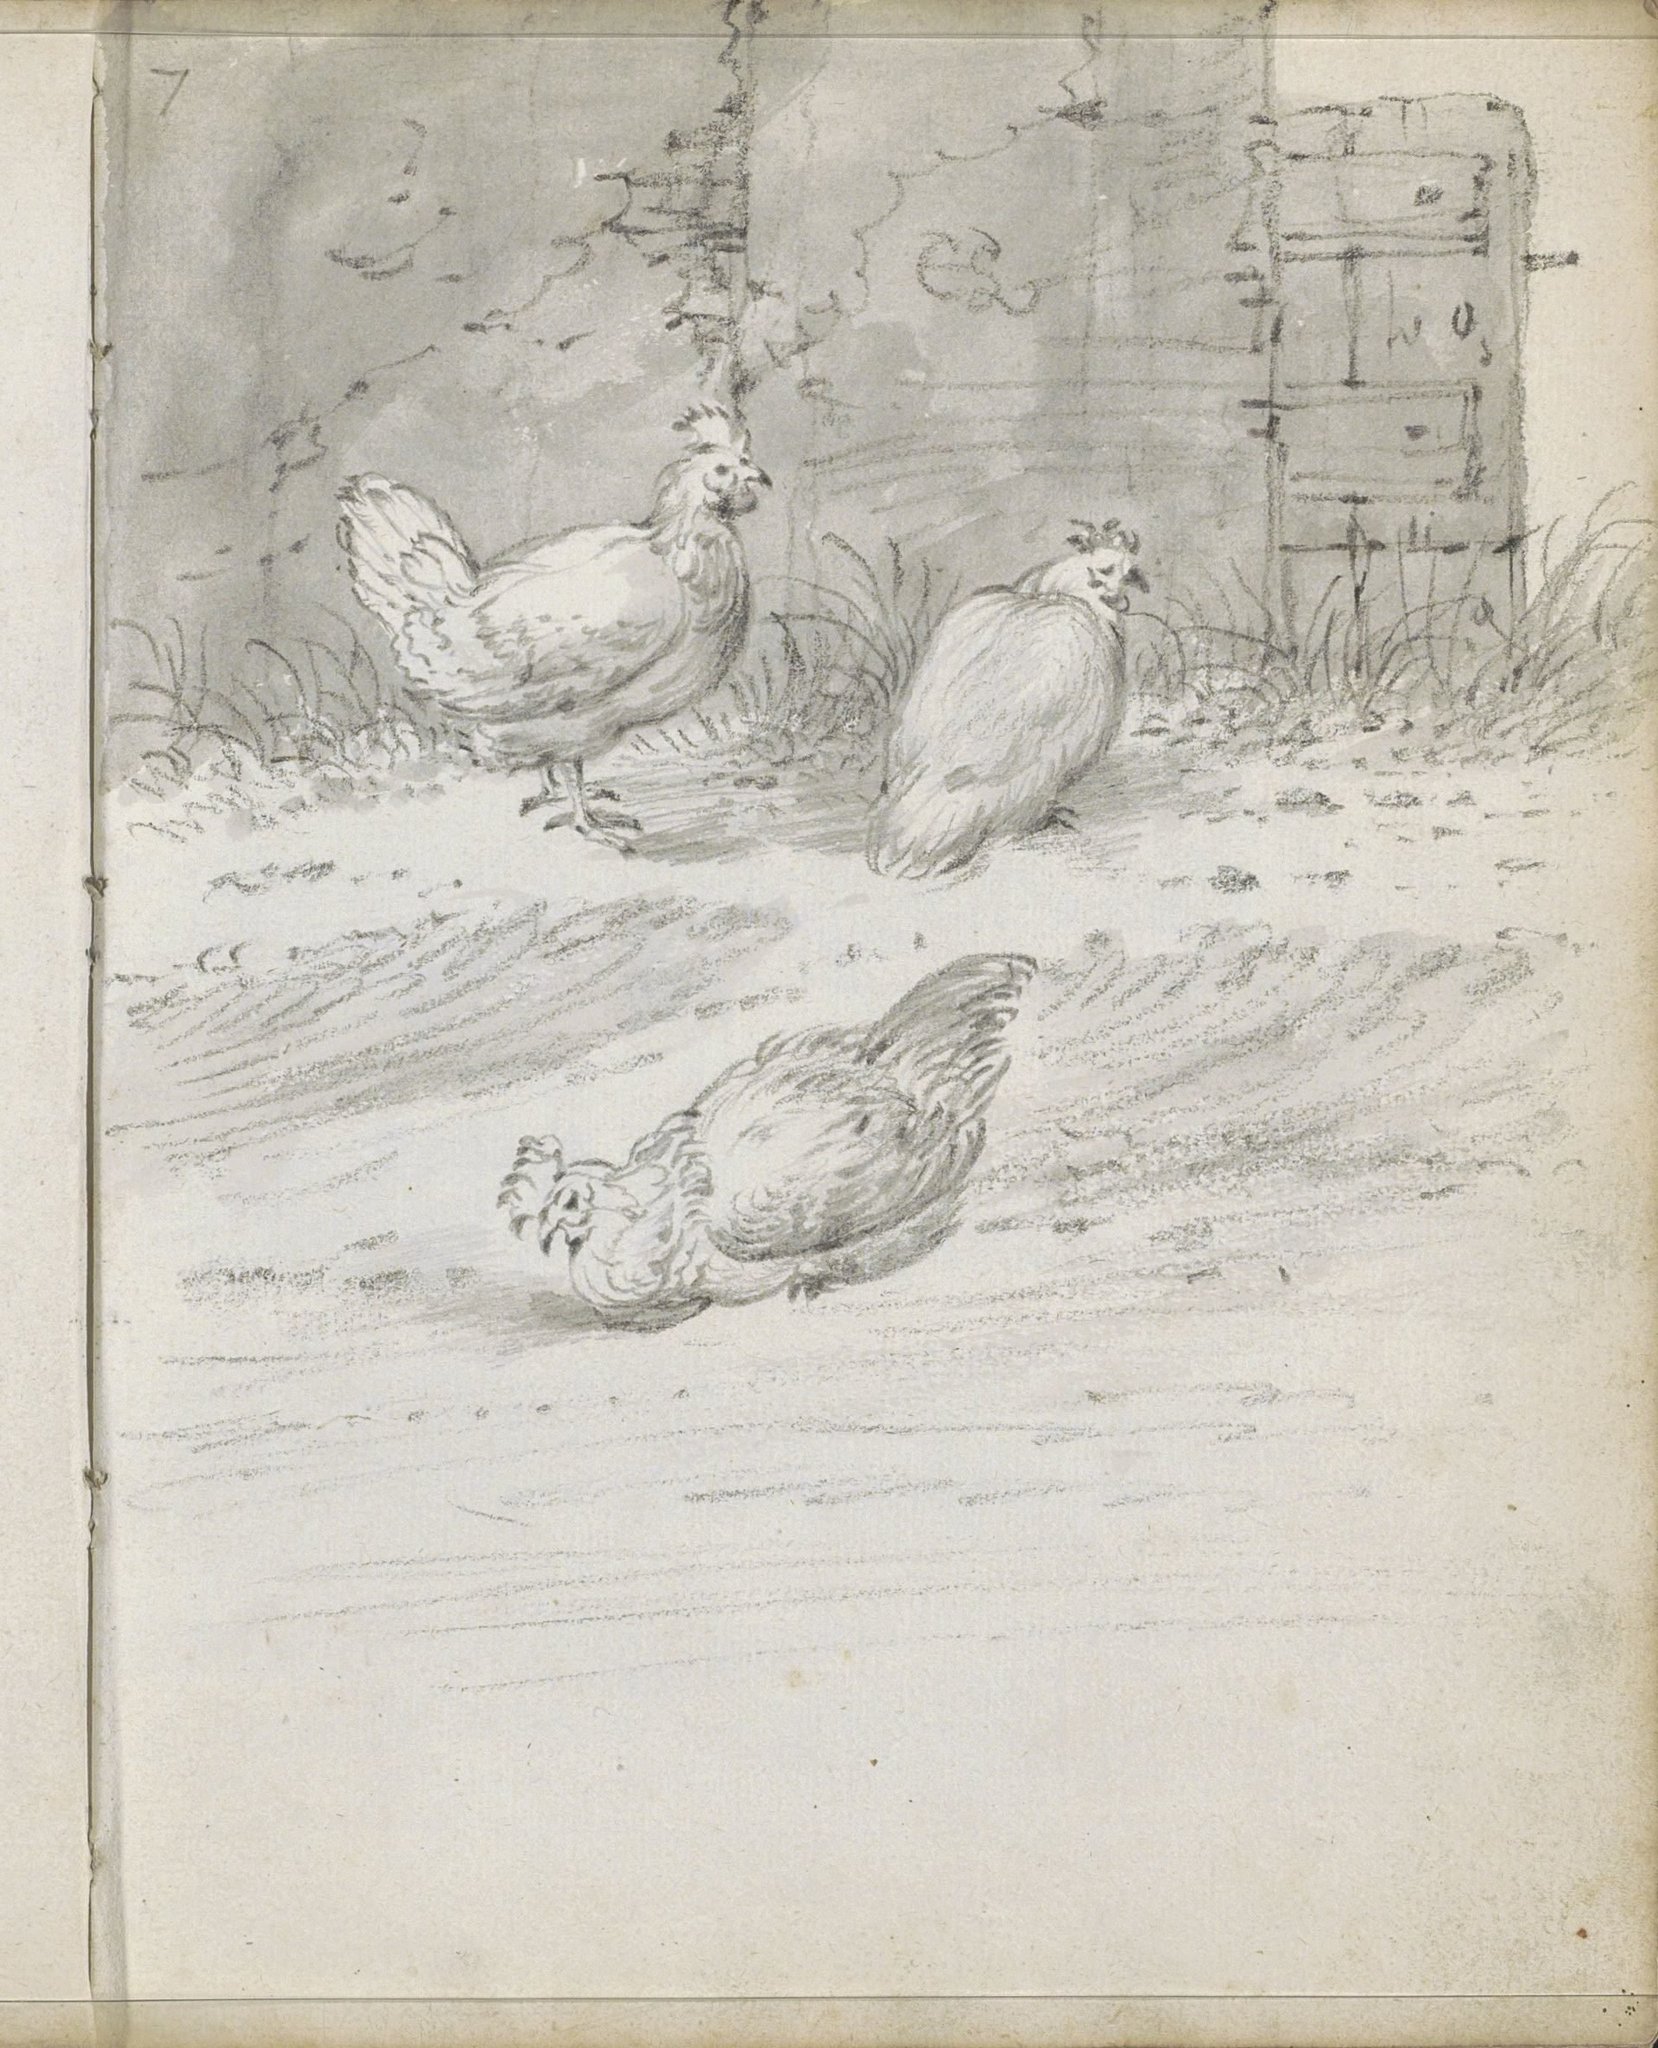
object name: sketchbook leaf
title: Kippen op een erf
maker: cornelis saftleven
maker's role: draughtsman, painter, print maker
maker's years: 1607-1681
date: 1666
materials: chalk, ink, paper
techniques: brush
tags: fowl (cock, hen, chicken, etc.)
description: Blad 7 recto uit een schetsboek met 49 bladen.